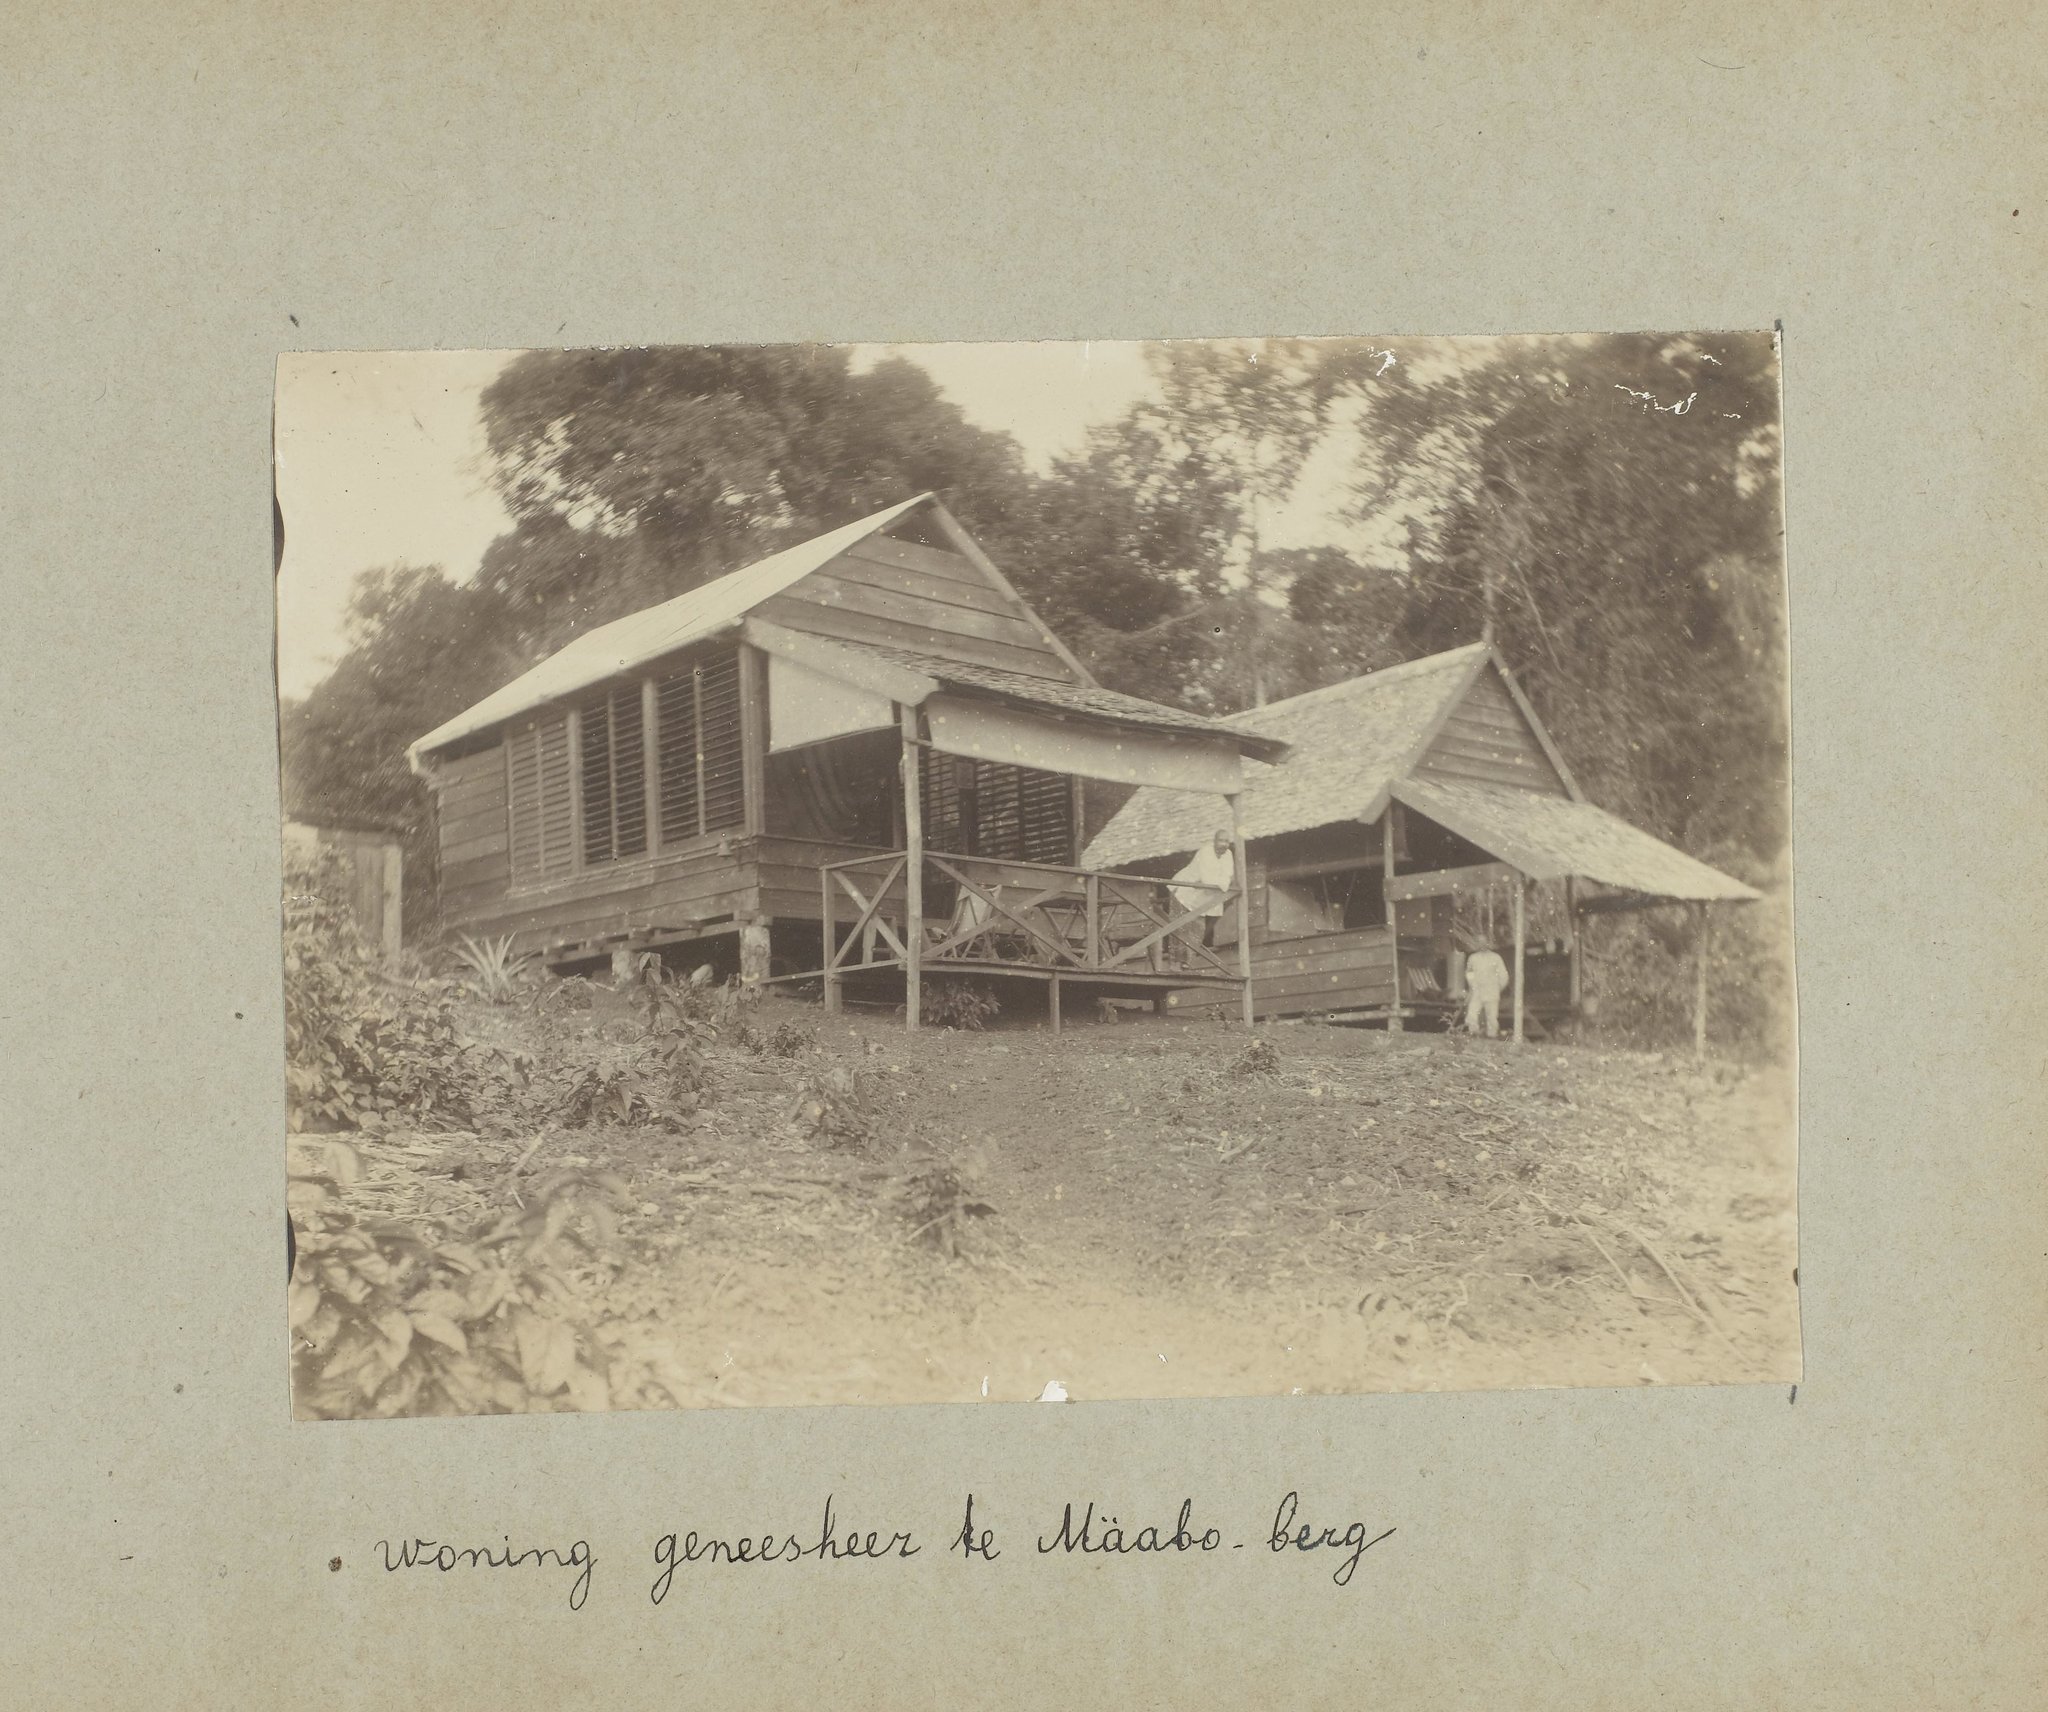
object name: photograph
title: Woning geneesheer te Mäabo-berg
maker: Anonymous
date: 1905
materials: photographic support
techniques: photography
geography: suriname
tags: jacob evert wesenhagen, railway, tramway; rack railway, suriname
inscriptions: inscription: ‘woning geneesheer te Mäabo-ber’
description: De woning van Jacob Evert Wesenhagen, kampgeneesheer, op de Maäbo Heuvel. Foto in het fotoalbum over de aanleg van de Lawaspoorweg in Suriname in de jaren 1903-1912. Onderdeel van een groep objecten afkomstig van de familie Wesenhagen in Suriname.